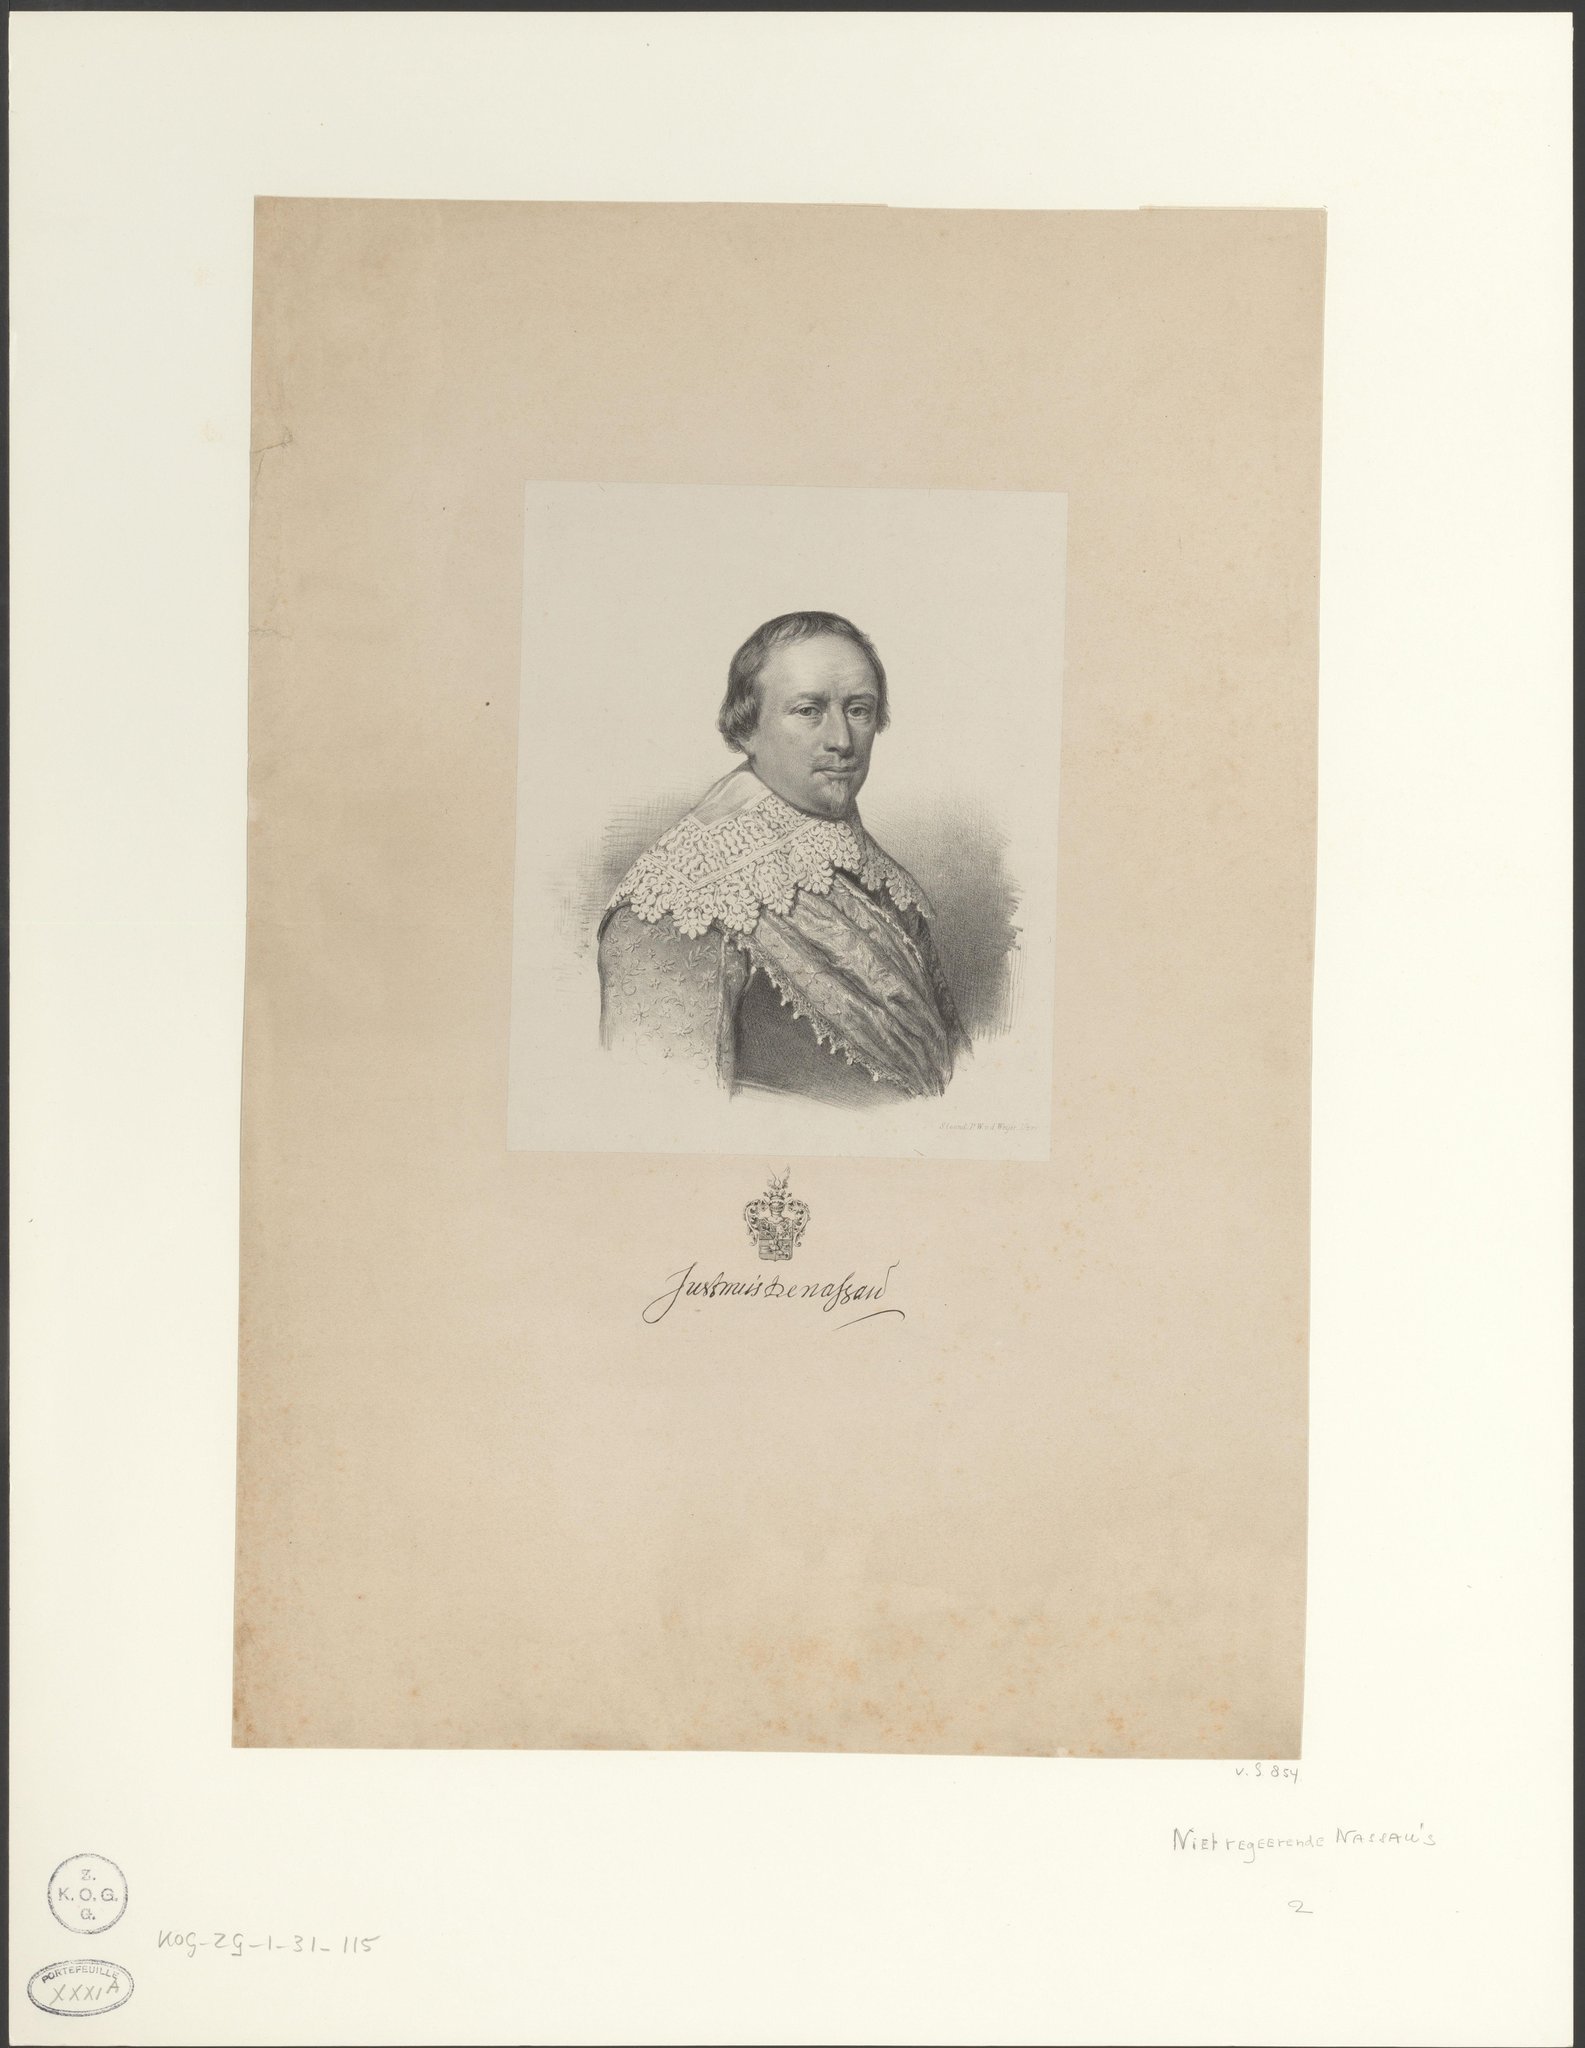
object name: print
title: Portret van Justinus van Nassau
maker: pieter wilhelmus van de weijer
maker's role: print maker, printer, publisher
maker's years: 1816-1880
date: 1826-1880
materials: paper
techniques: lithograph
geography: utrecht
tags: historical persons (+ (full) bust portrait)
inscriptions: stamp, collector's mark: Lugt 1641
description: Onder het portret een facsimile van het facsimile van de geportretteerde. Onderwerpsrubrieken binnen de Atlas Zeden en Gewoonten: Portretten, Portretten van Vorsten uit het huis van Oranje, Niet regeerende Vorsten.